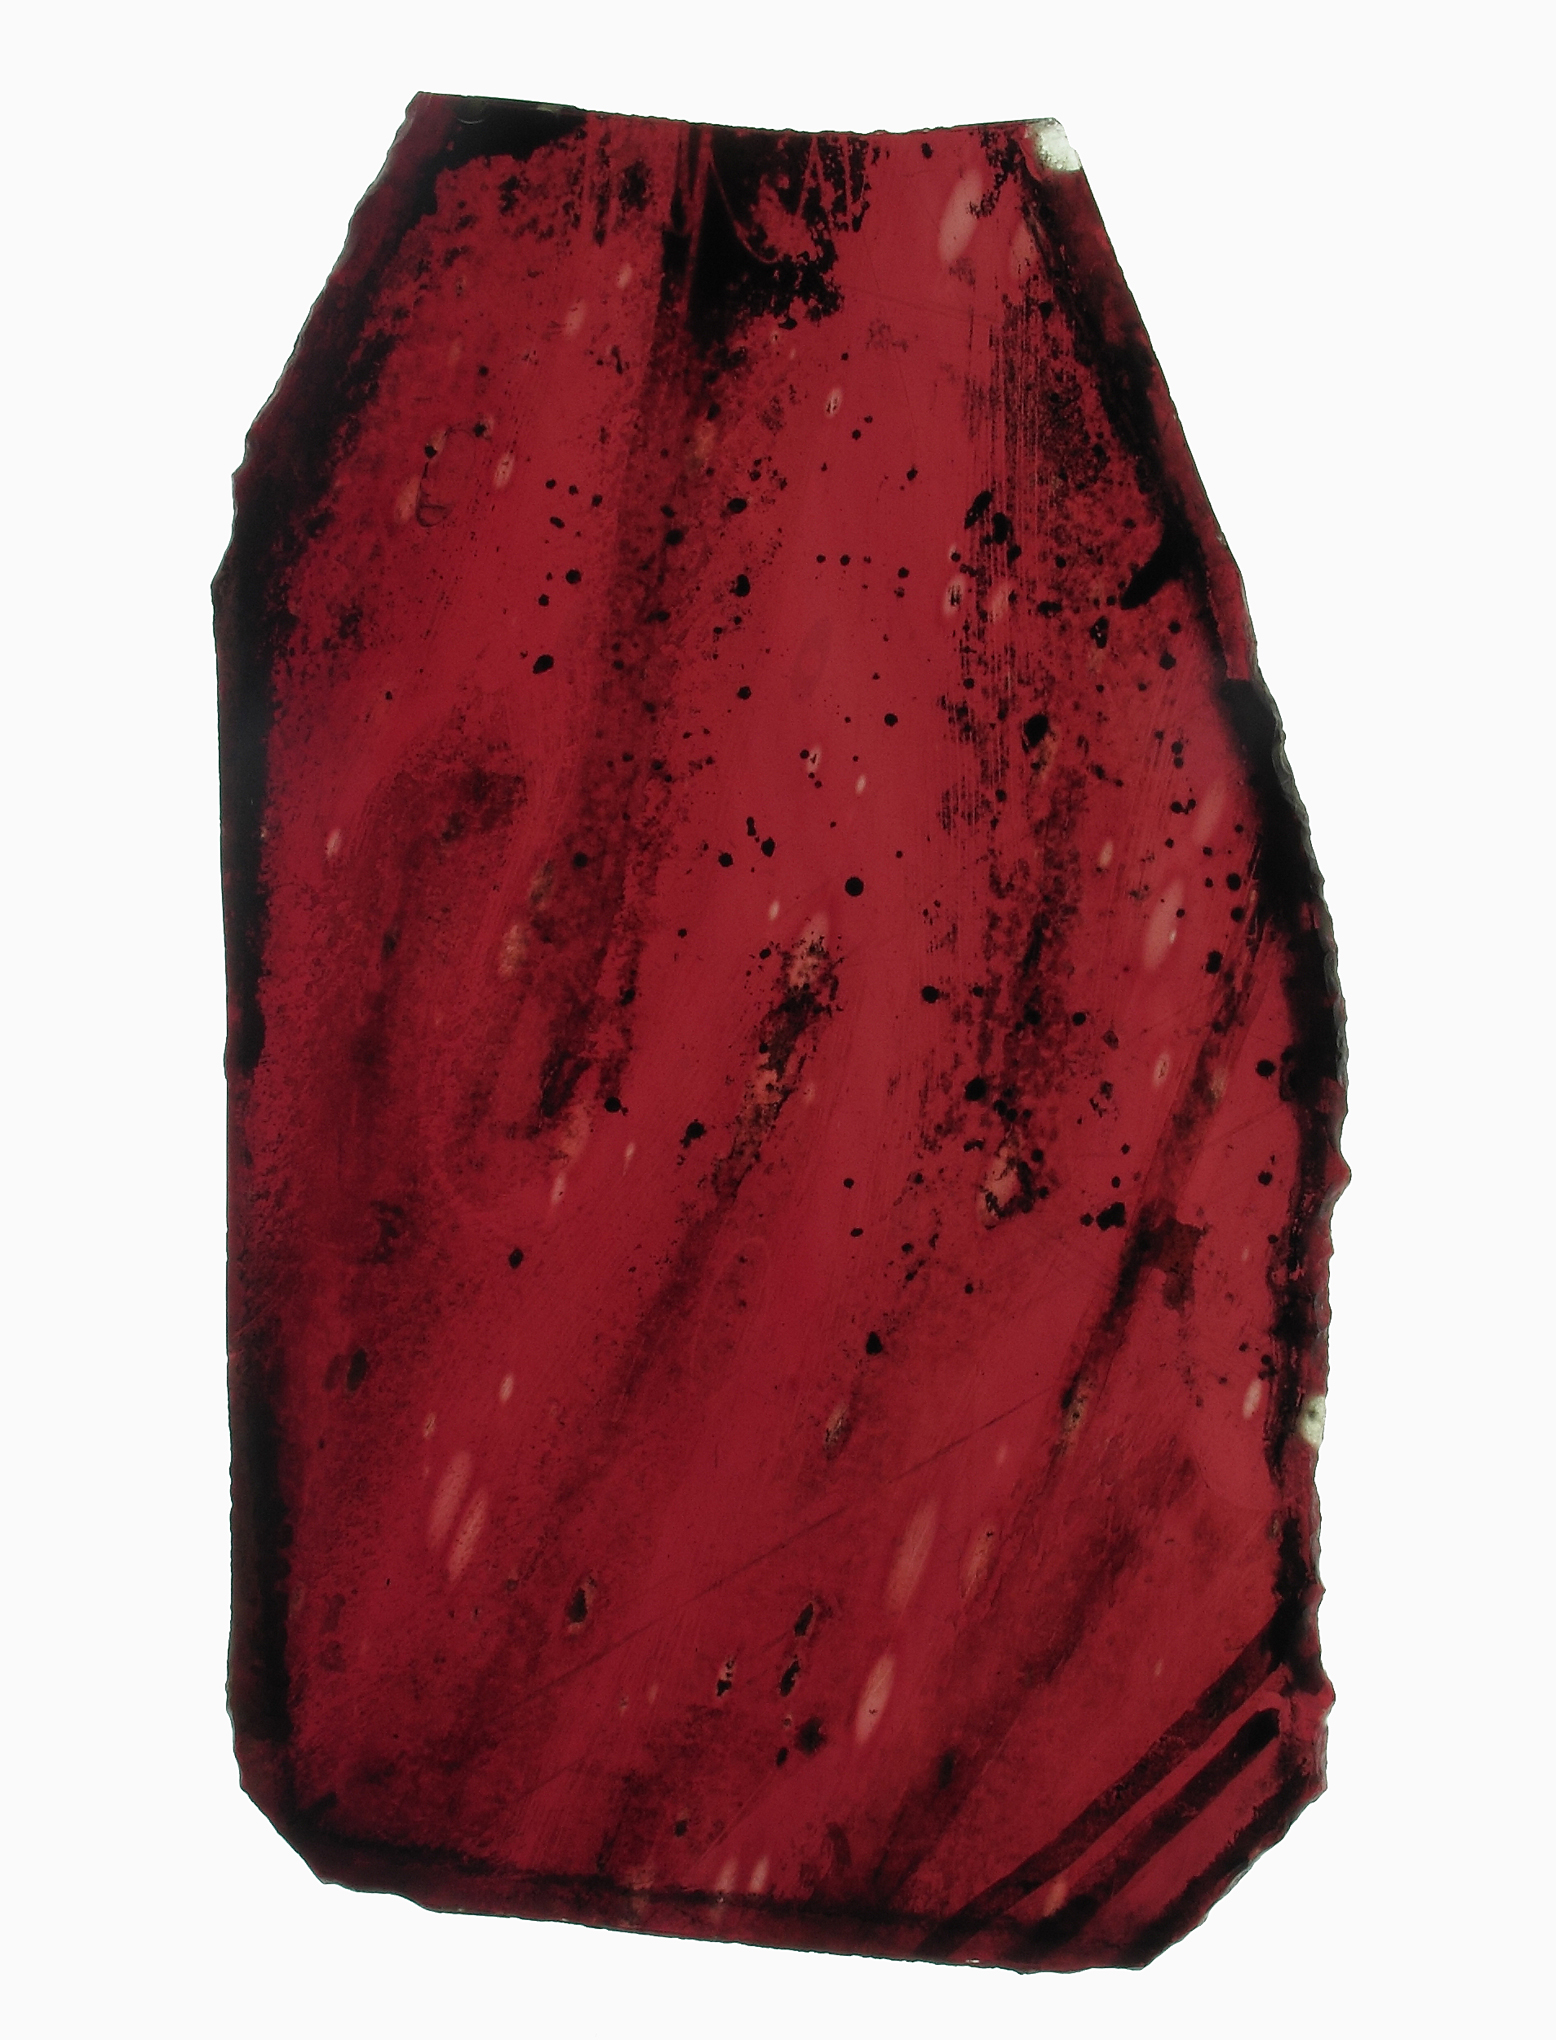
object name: fragment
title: Glass Fragment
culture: european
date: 1501-1600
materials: glass, metal